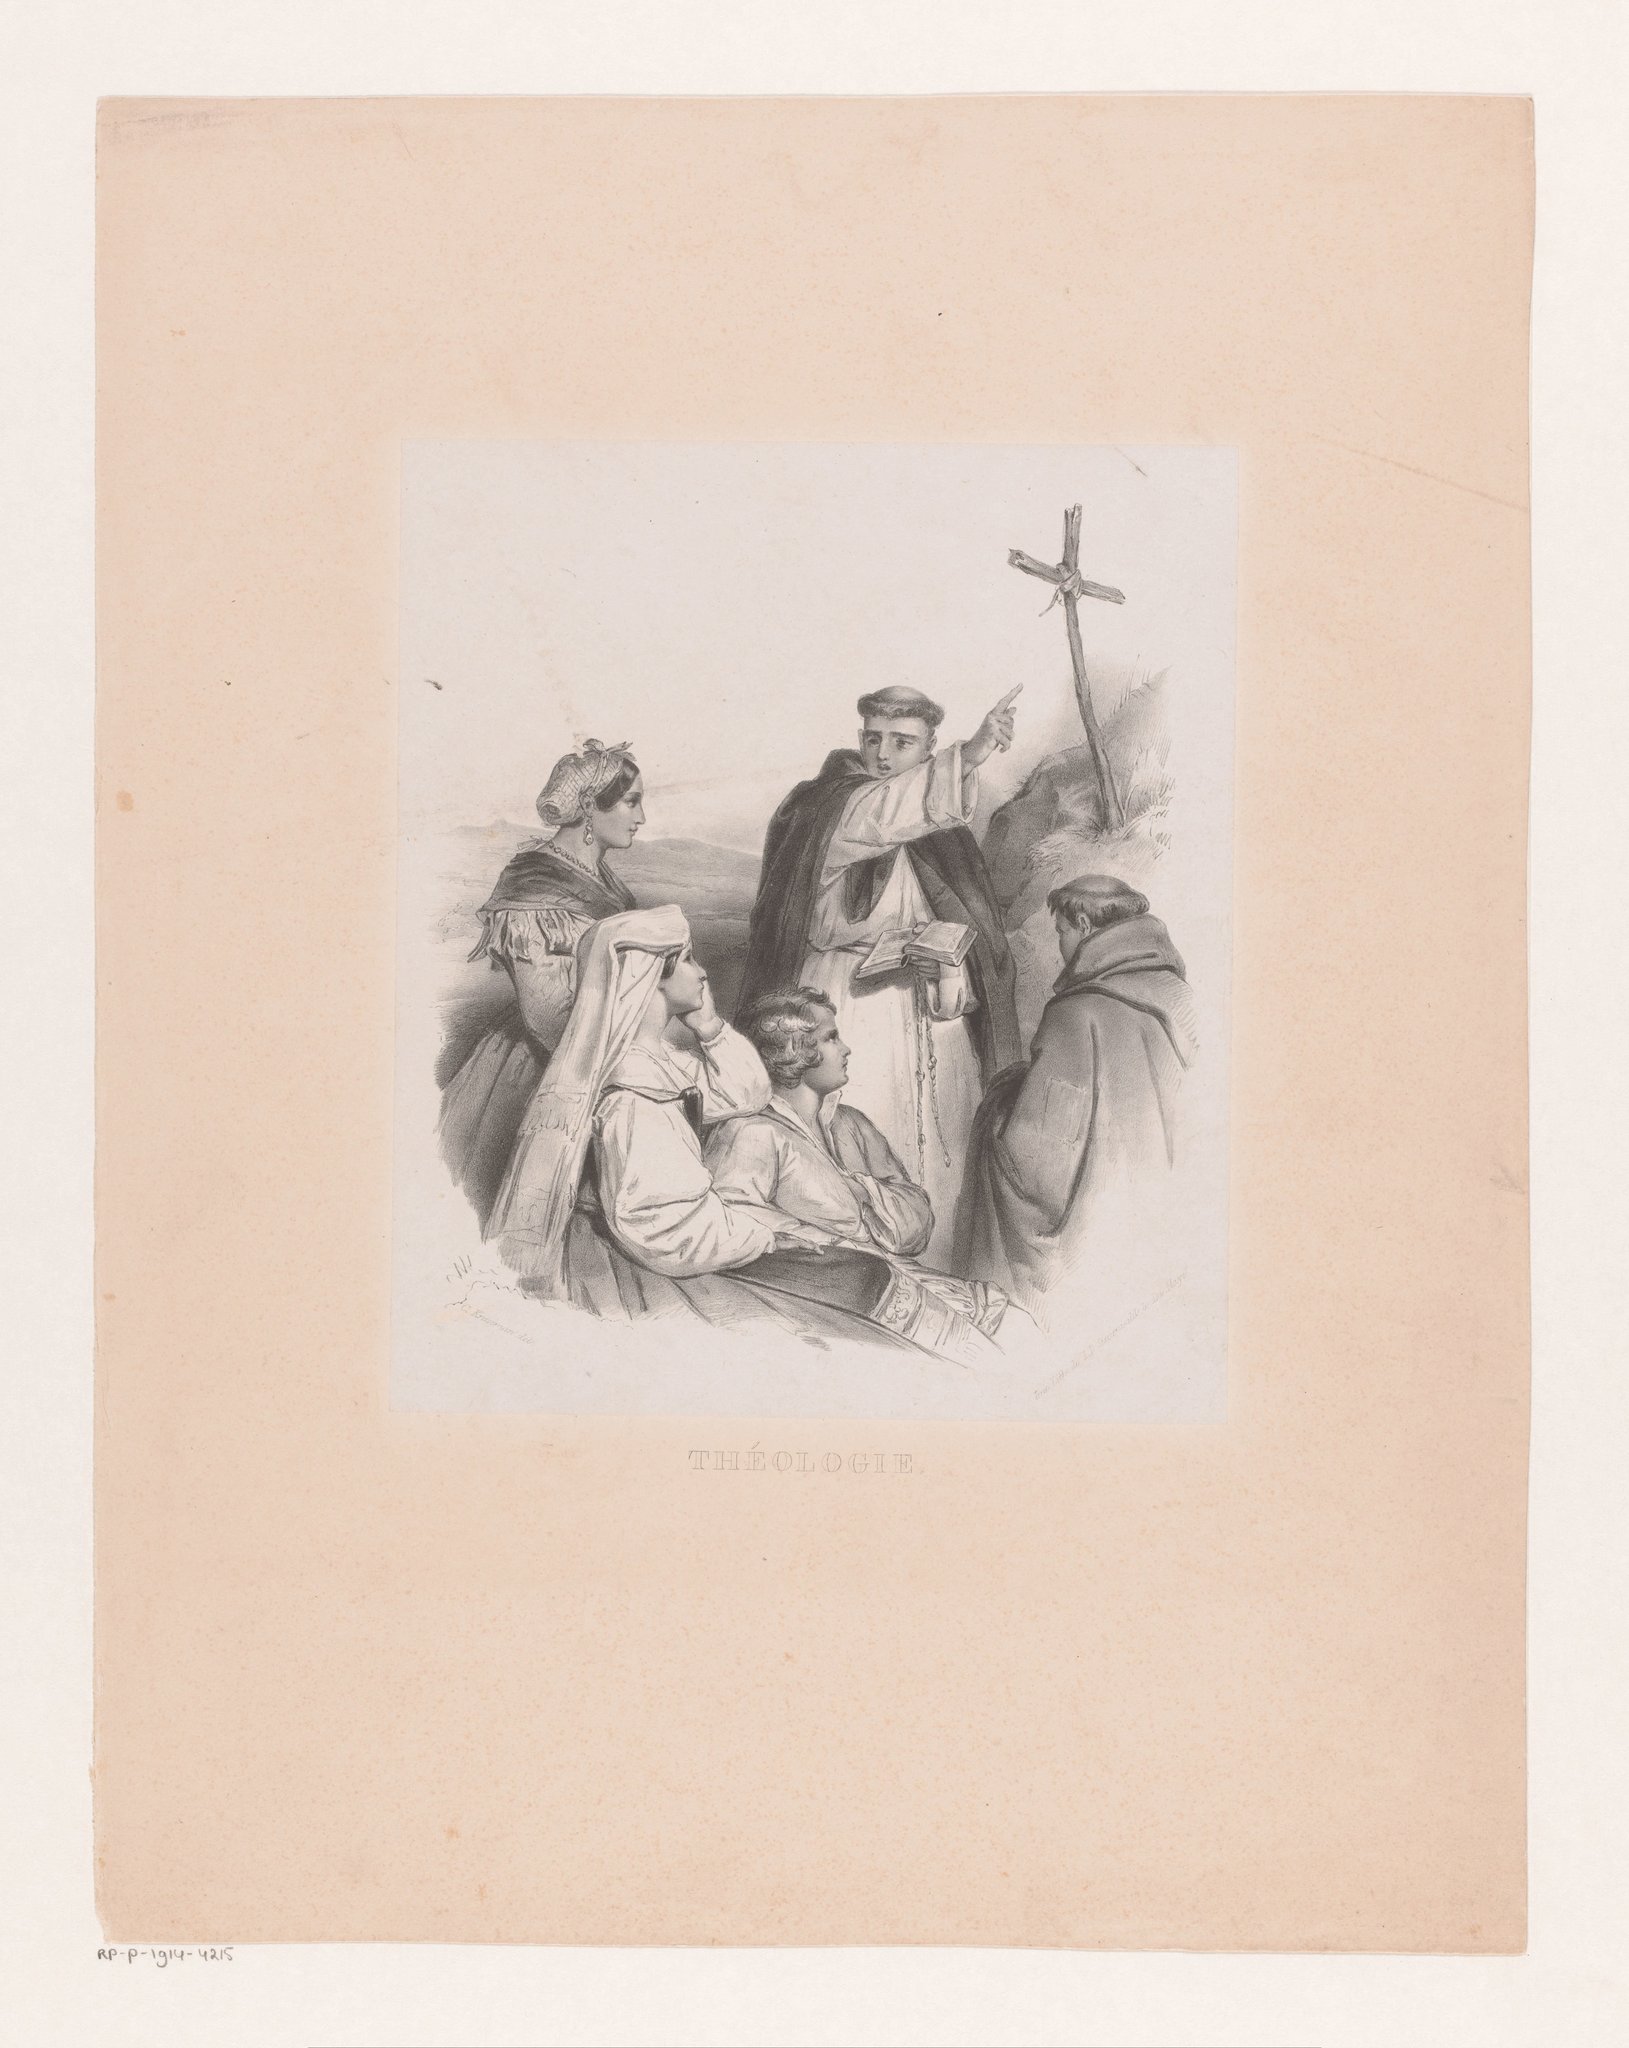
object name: print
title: Théologie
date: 1833-1863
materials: paper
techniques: lithograph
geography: the hague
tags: cross as symbol of christ, monk(s), friar(s)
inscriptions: collector's mark: Lugt 2228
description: Een van de twee monniken wijst naar een houten kruis op een heuvel. Twee vrouwen en een jongen kijken ernaar.